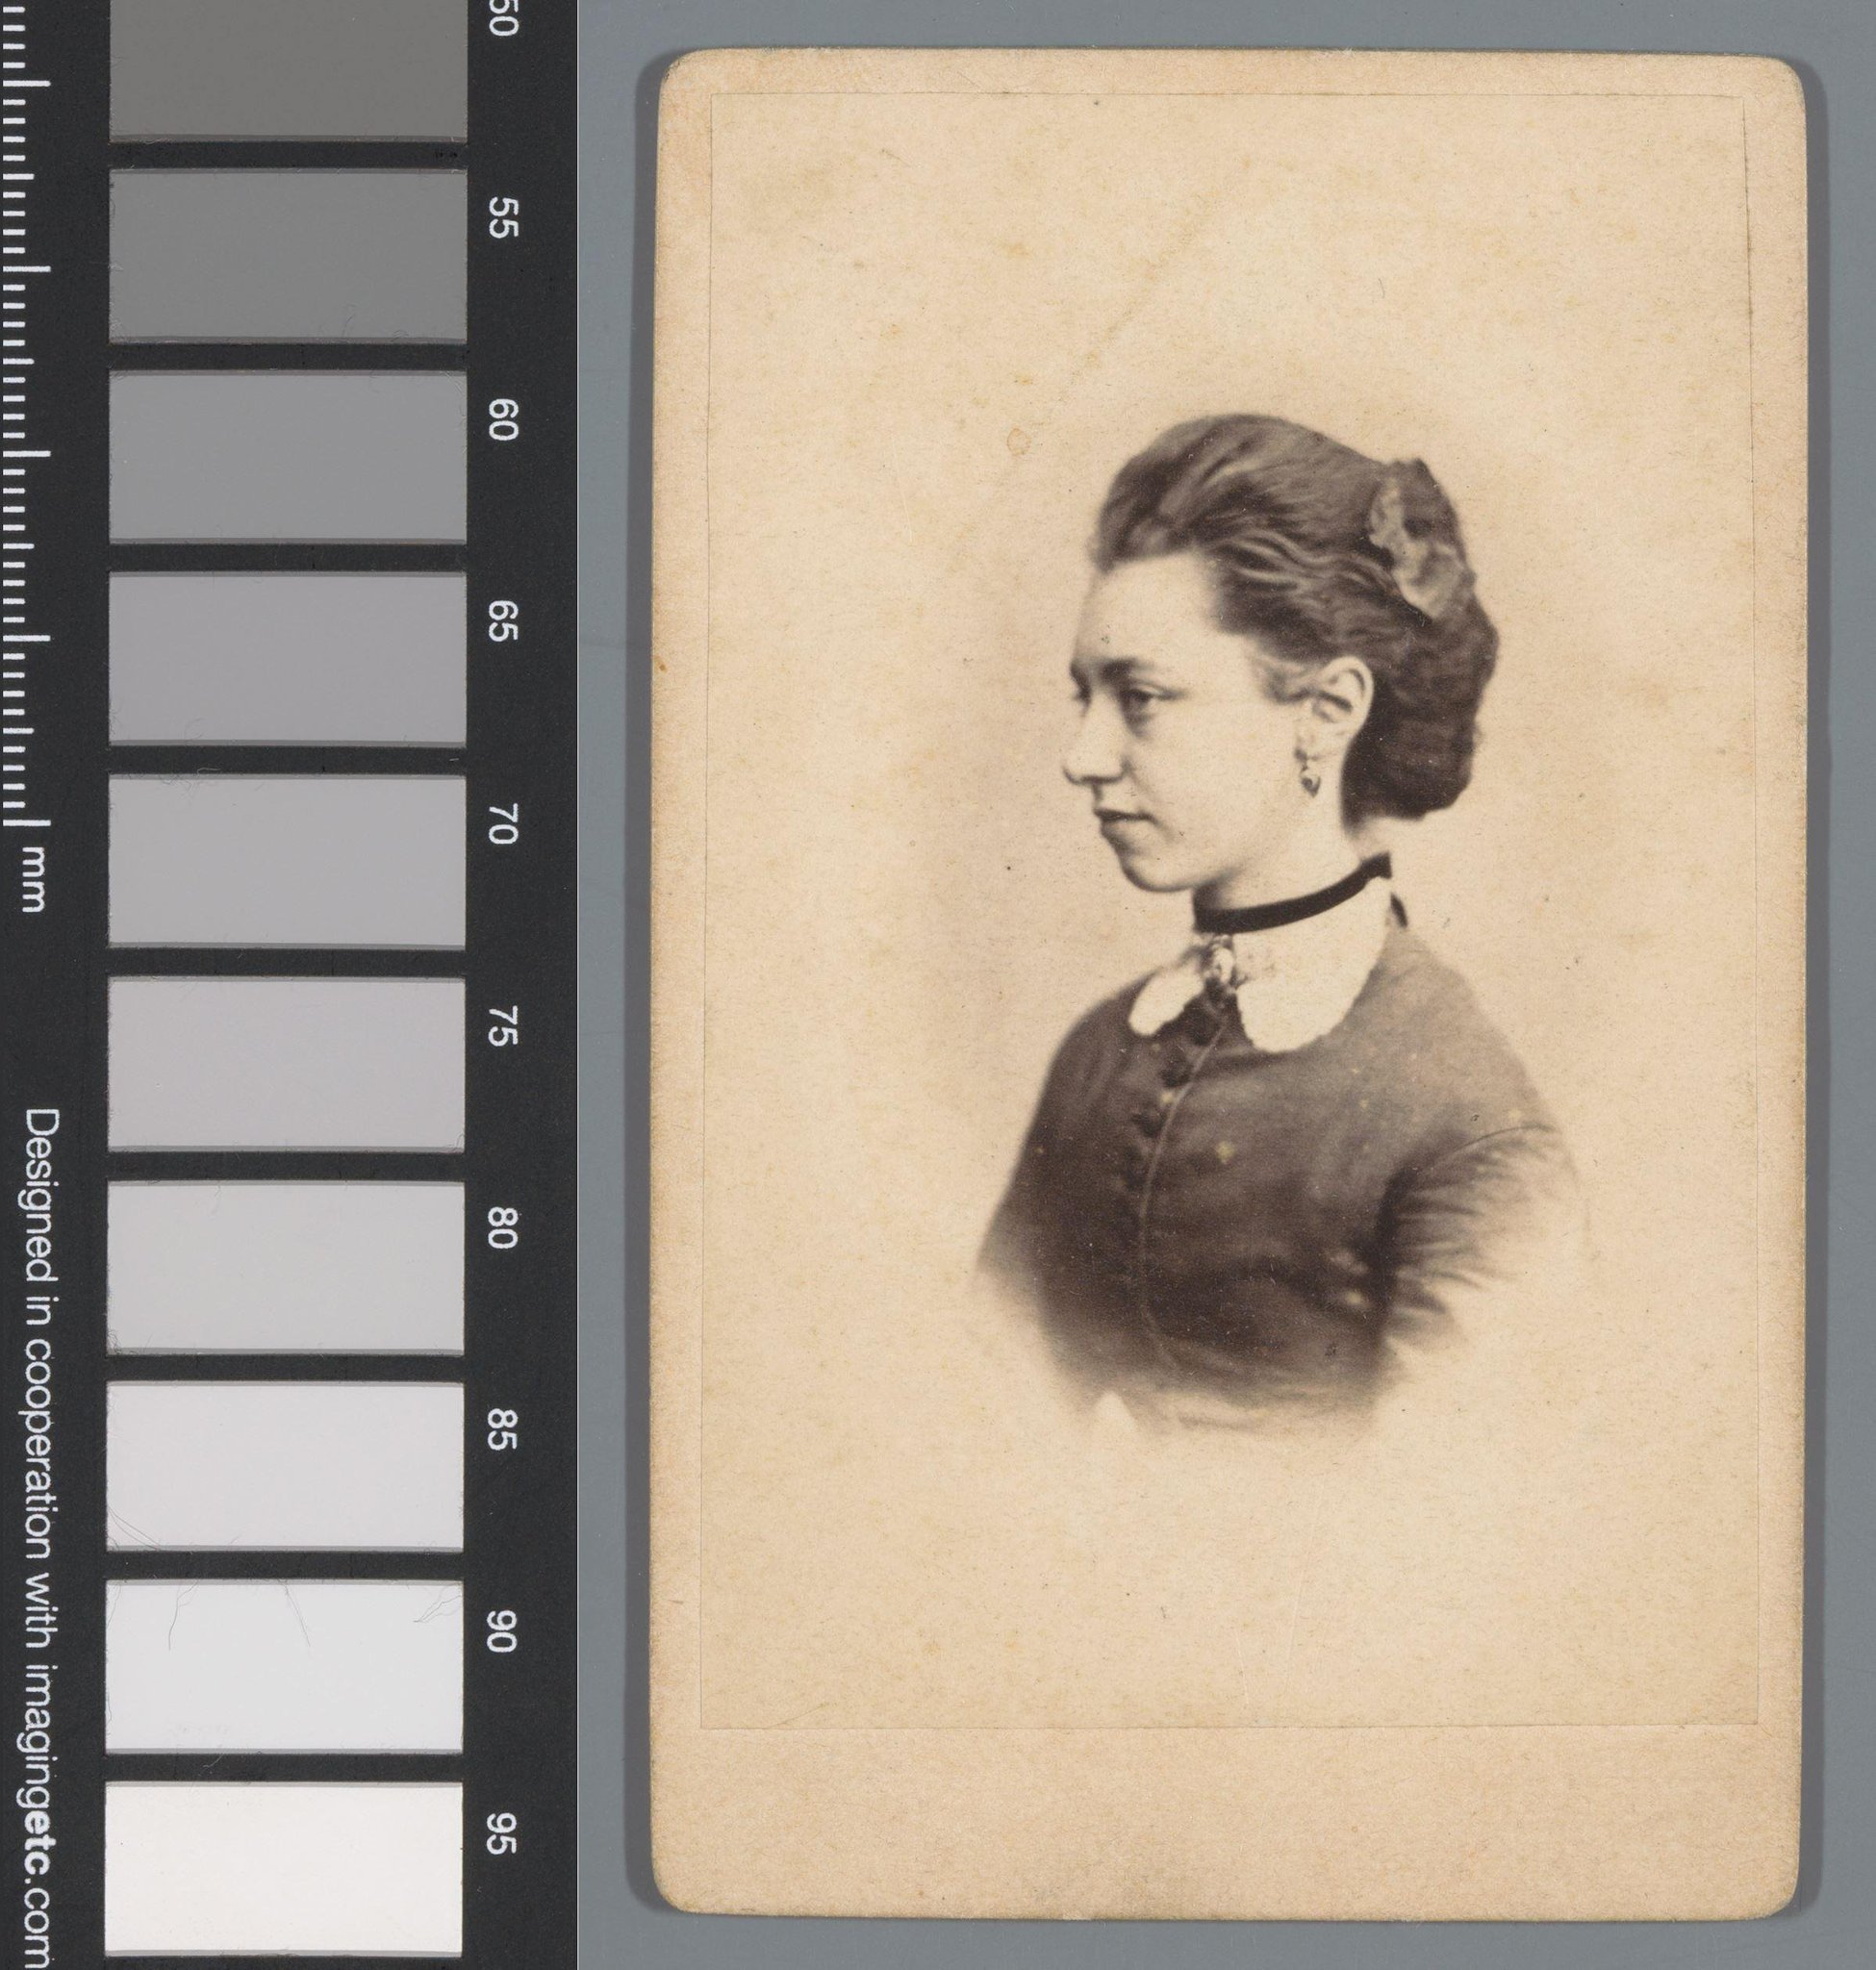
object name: carte de visite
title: Portret van een onbekende vrouw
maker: friedrich heuberg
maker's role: fotograaf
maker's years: 1840-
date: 1869-1879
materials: cardboard, paper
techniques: albumen print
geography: amsterdam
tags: historical persons - bb - woman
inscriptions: inscription: ‘Engelsch Photographisch/ ETABLISSEMENT/ von/ F. Heuberg/ Firma: C. MARCUSSEN./ AMSTERDAM/ Kalverstraat bij de Munt D. 39.’